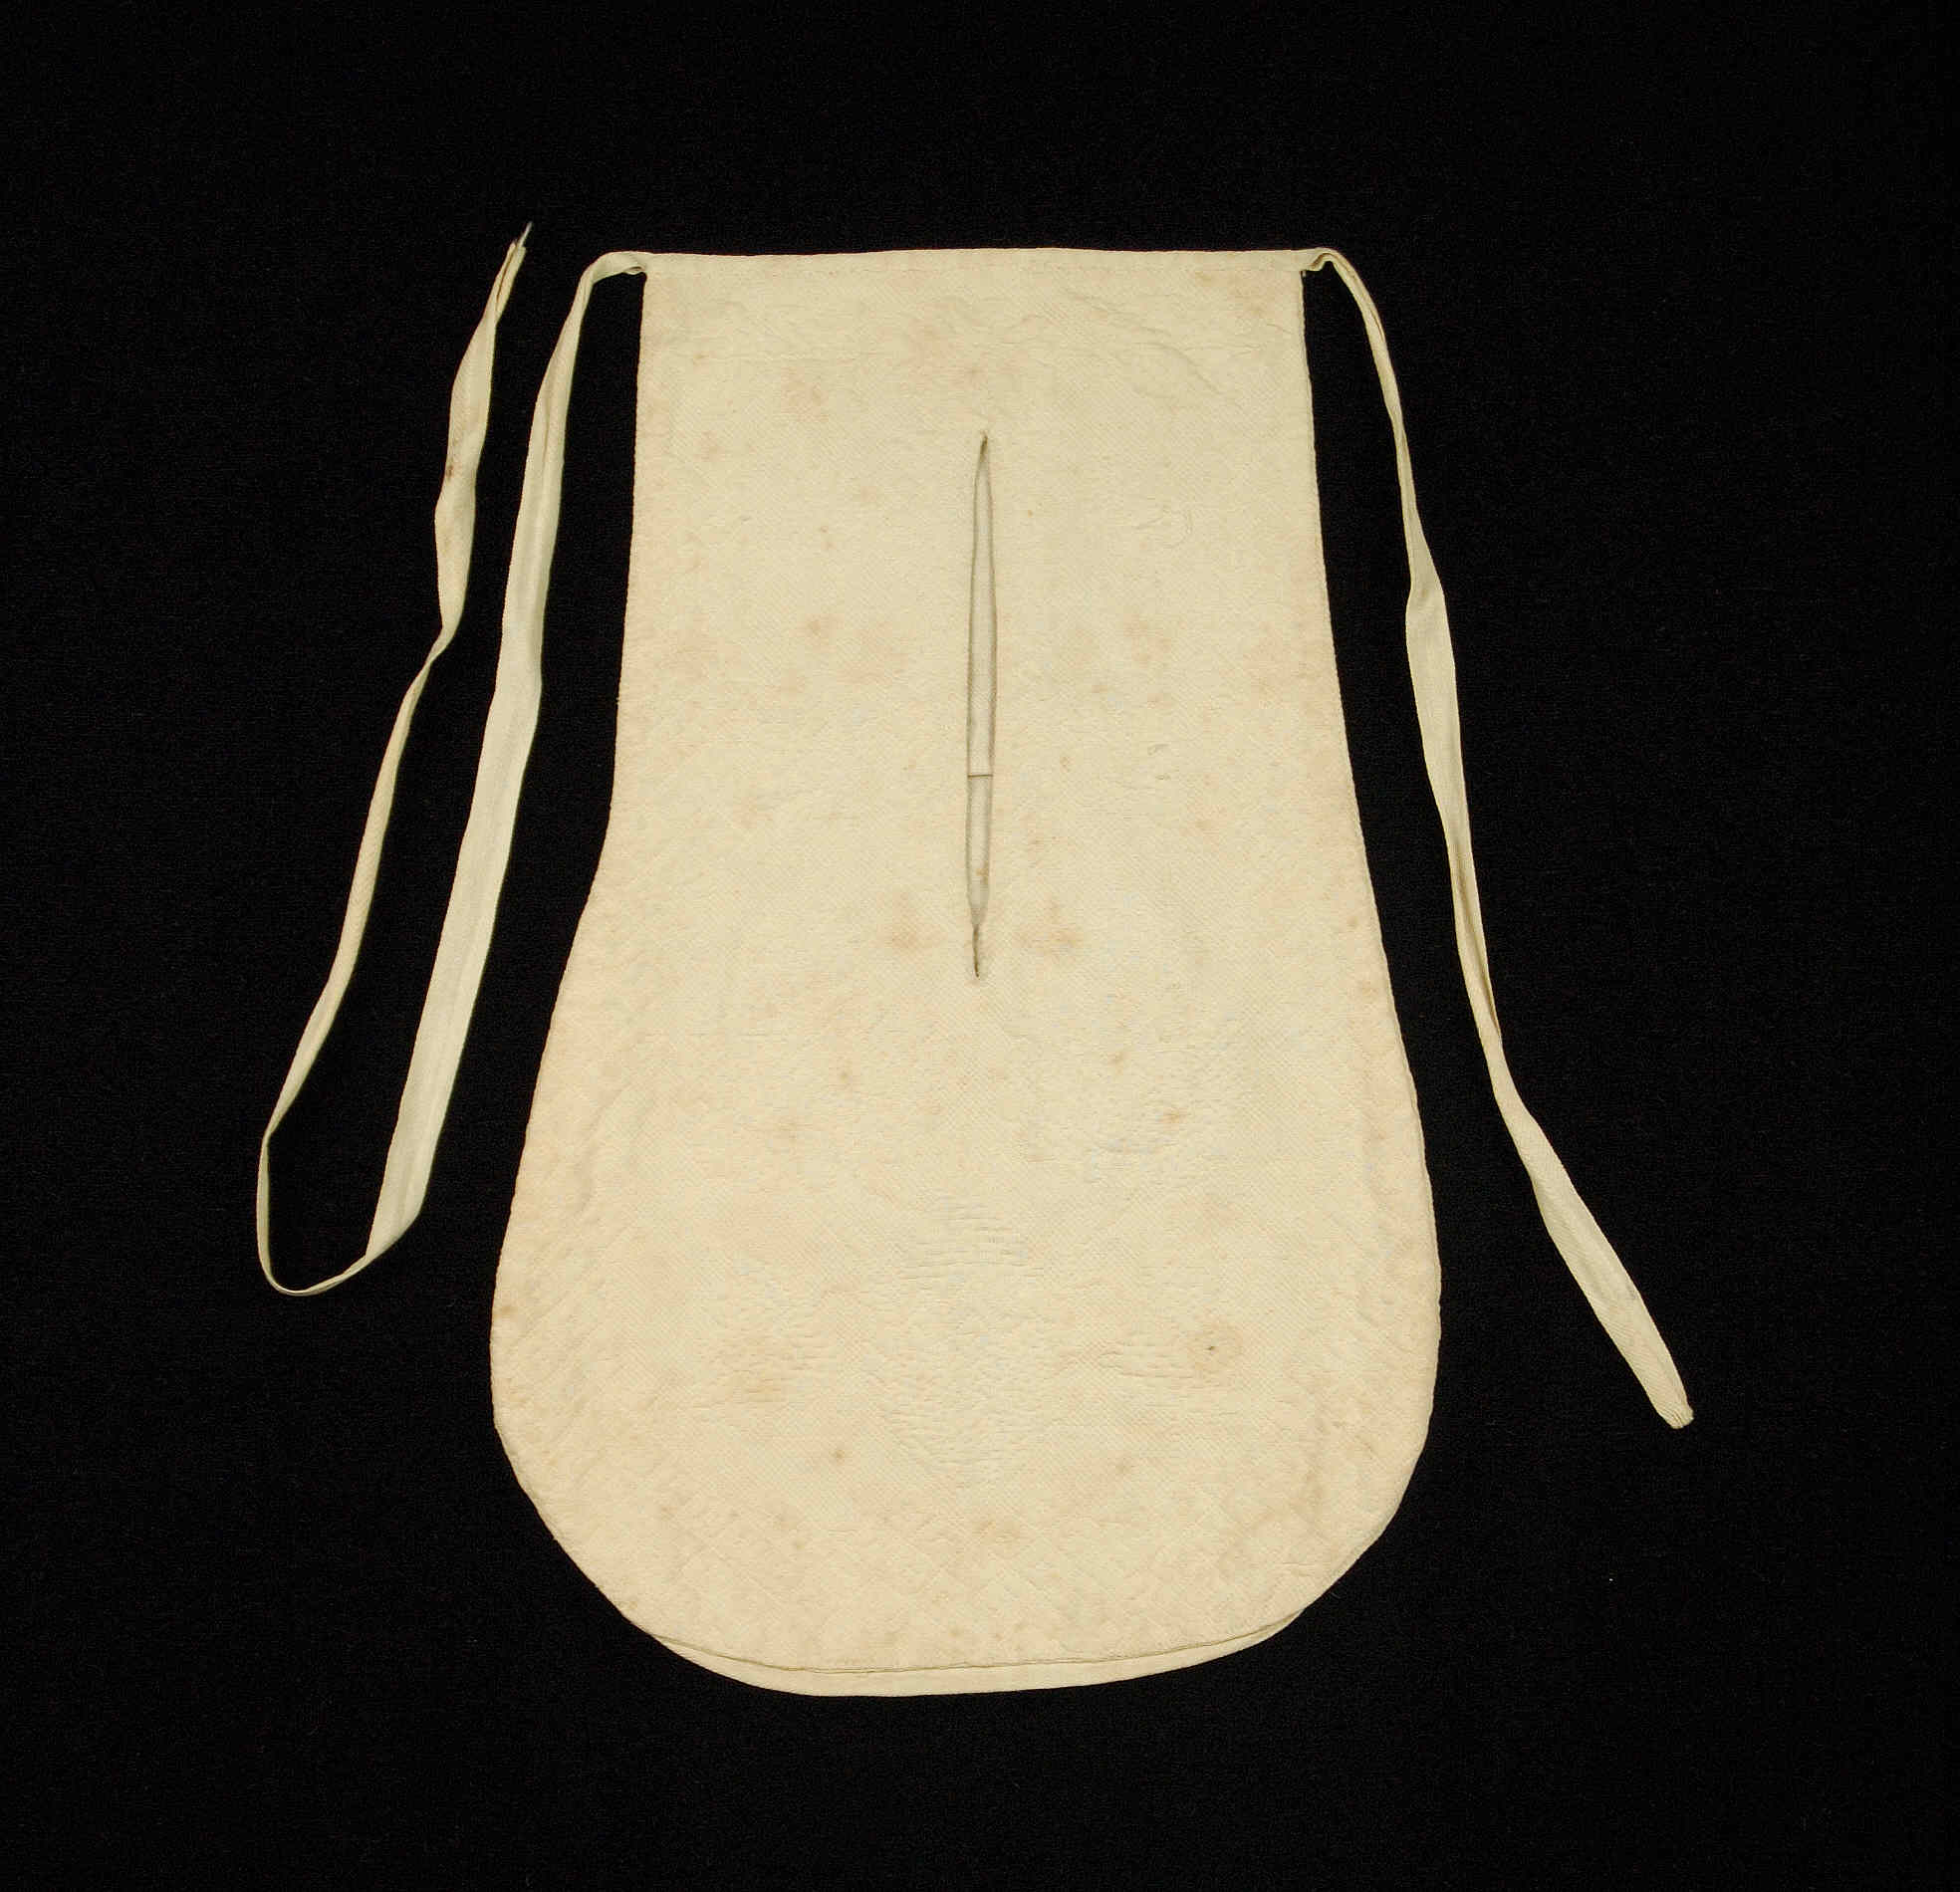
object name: pocket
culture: american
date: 1800-1810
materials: cotton